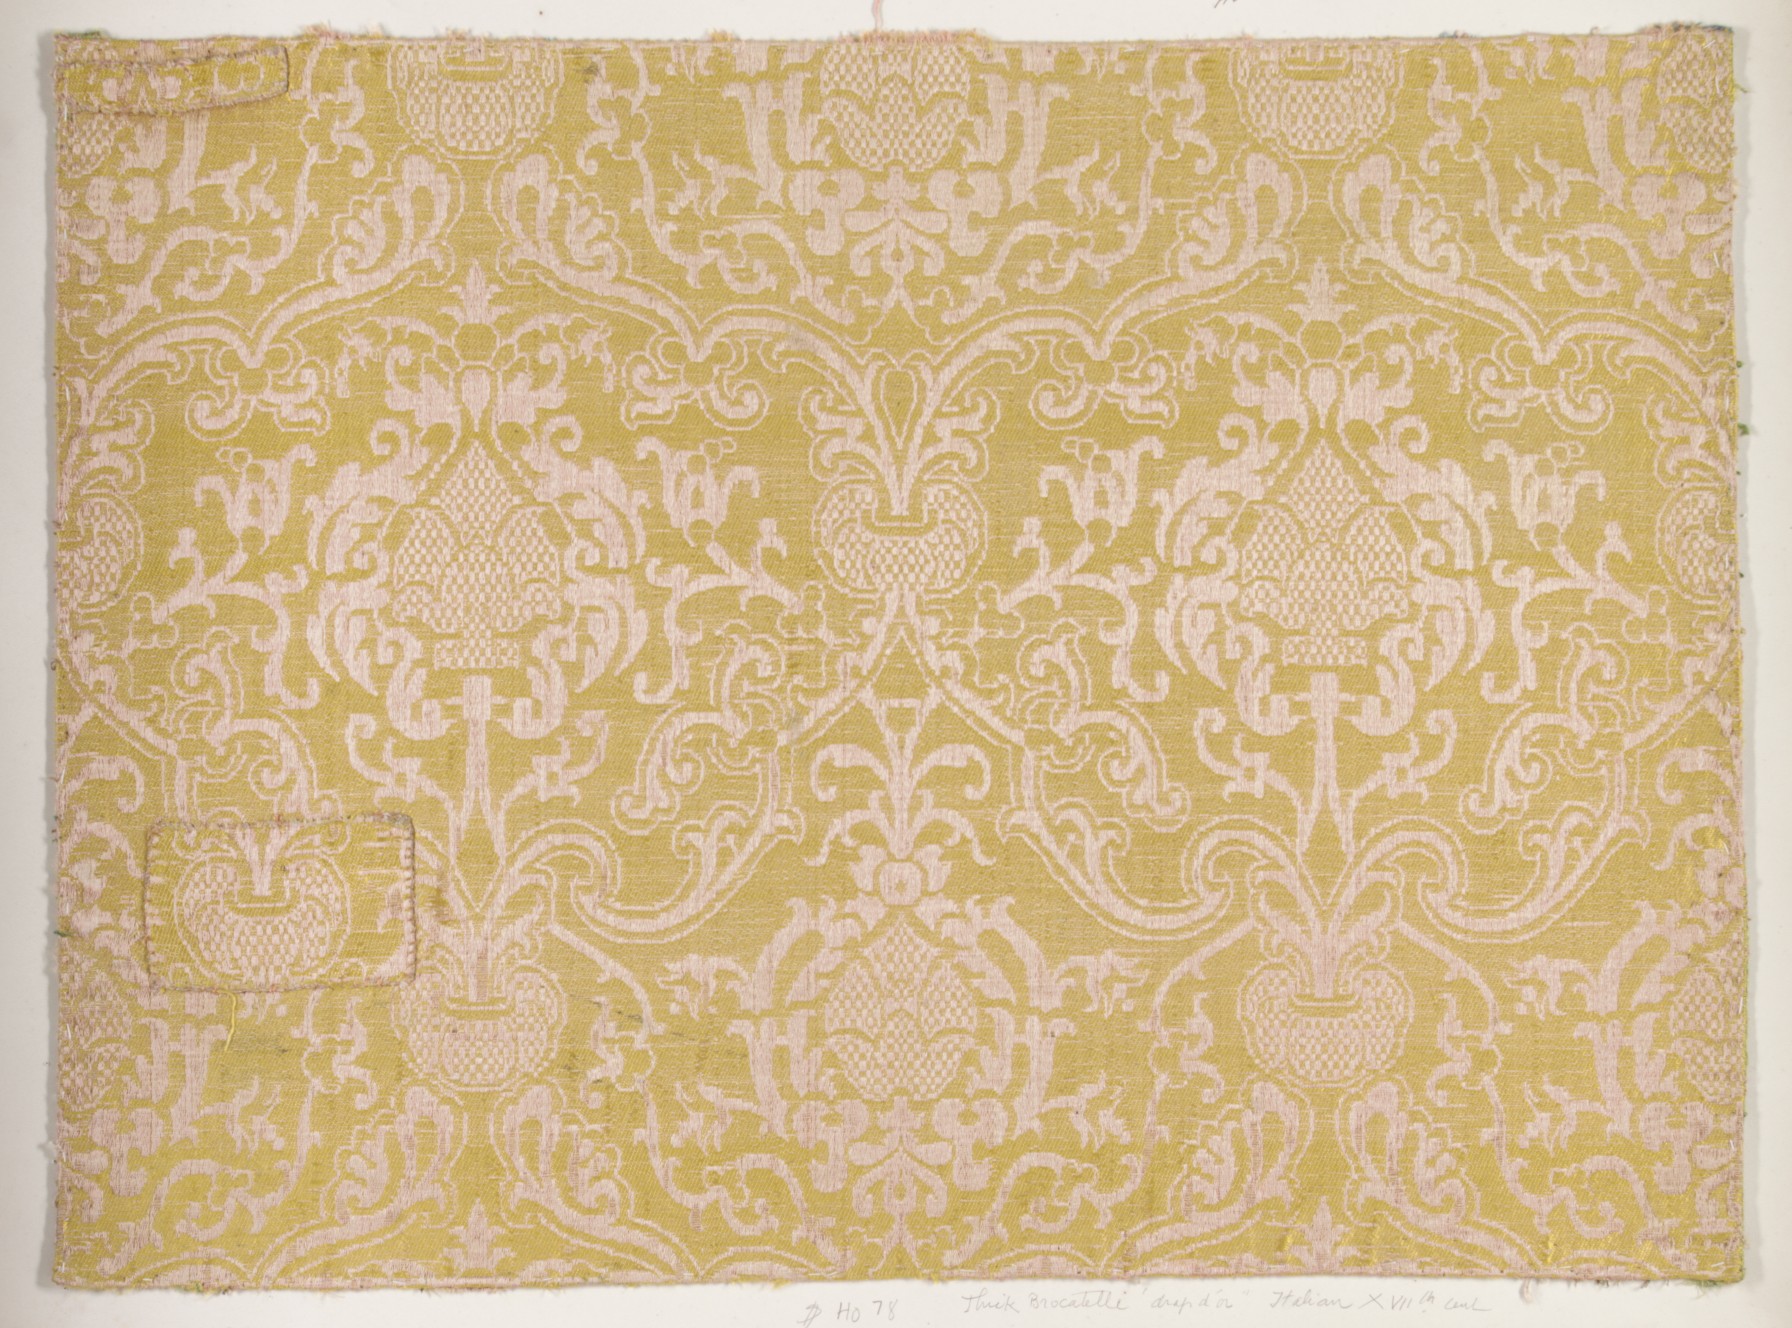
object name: fragment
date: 1601-1700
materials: silk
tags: leaves